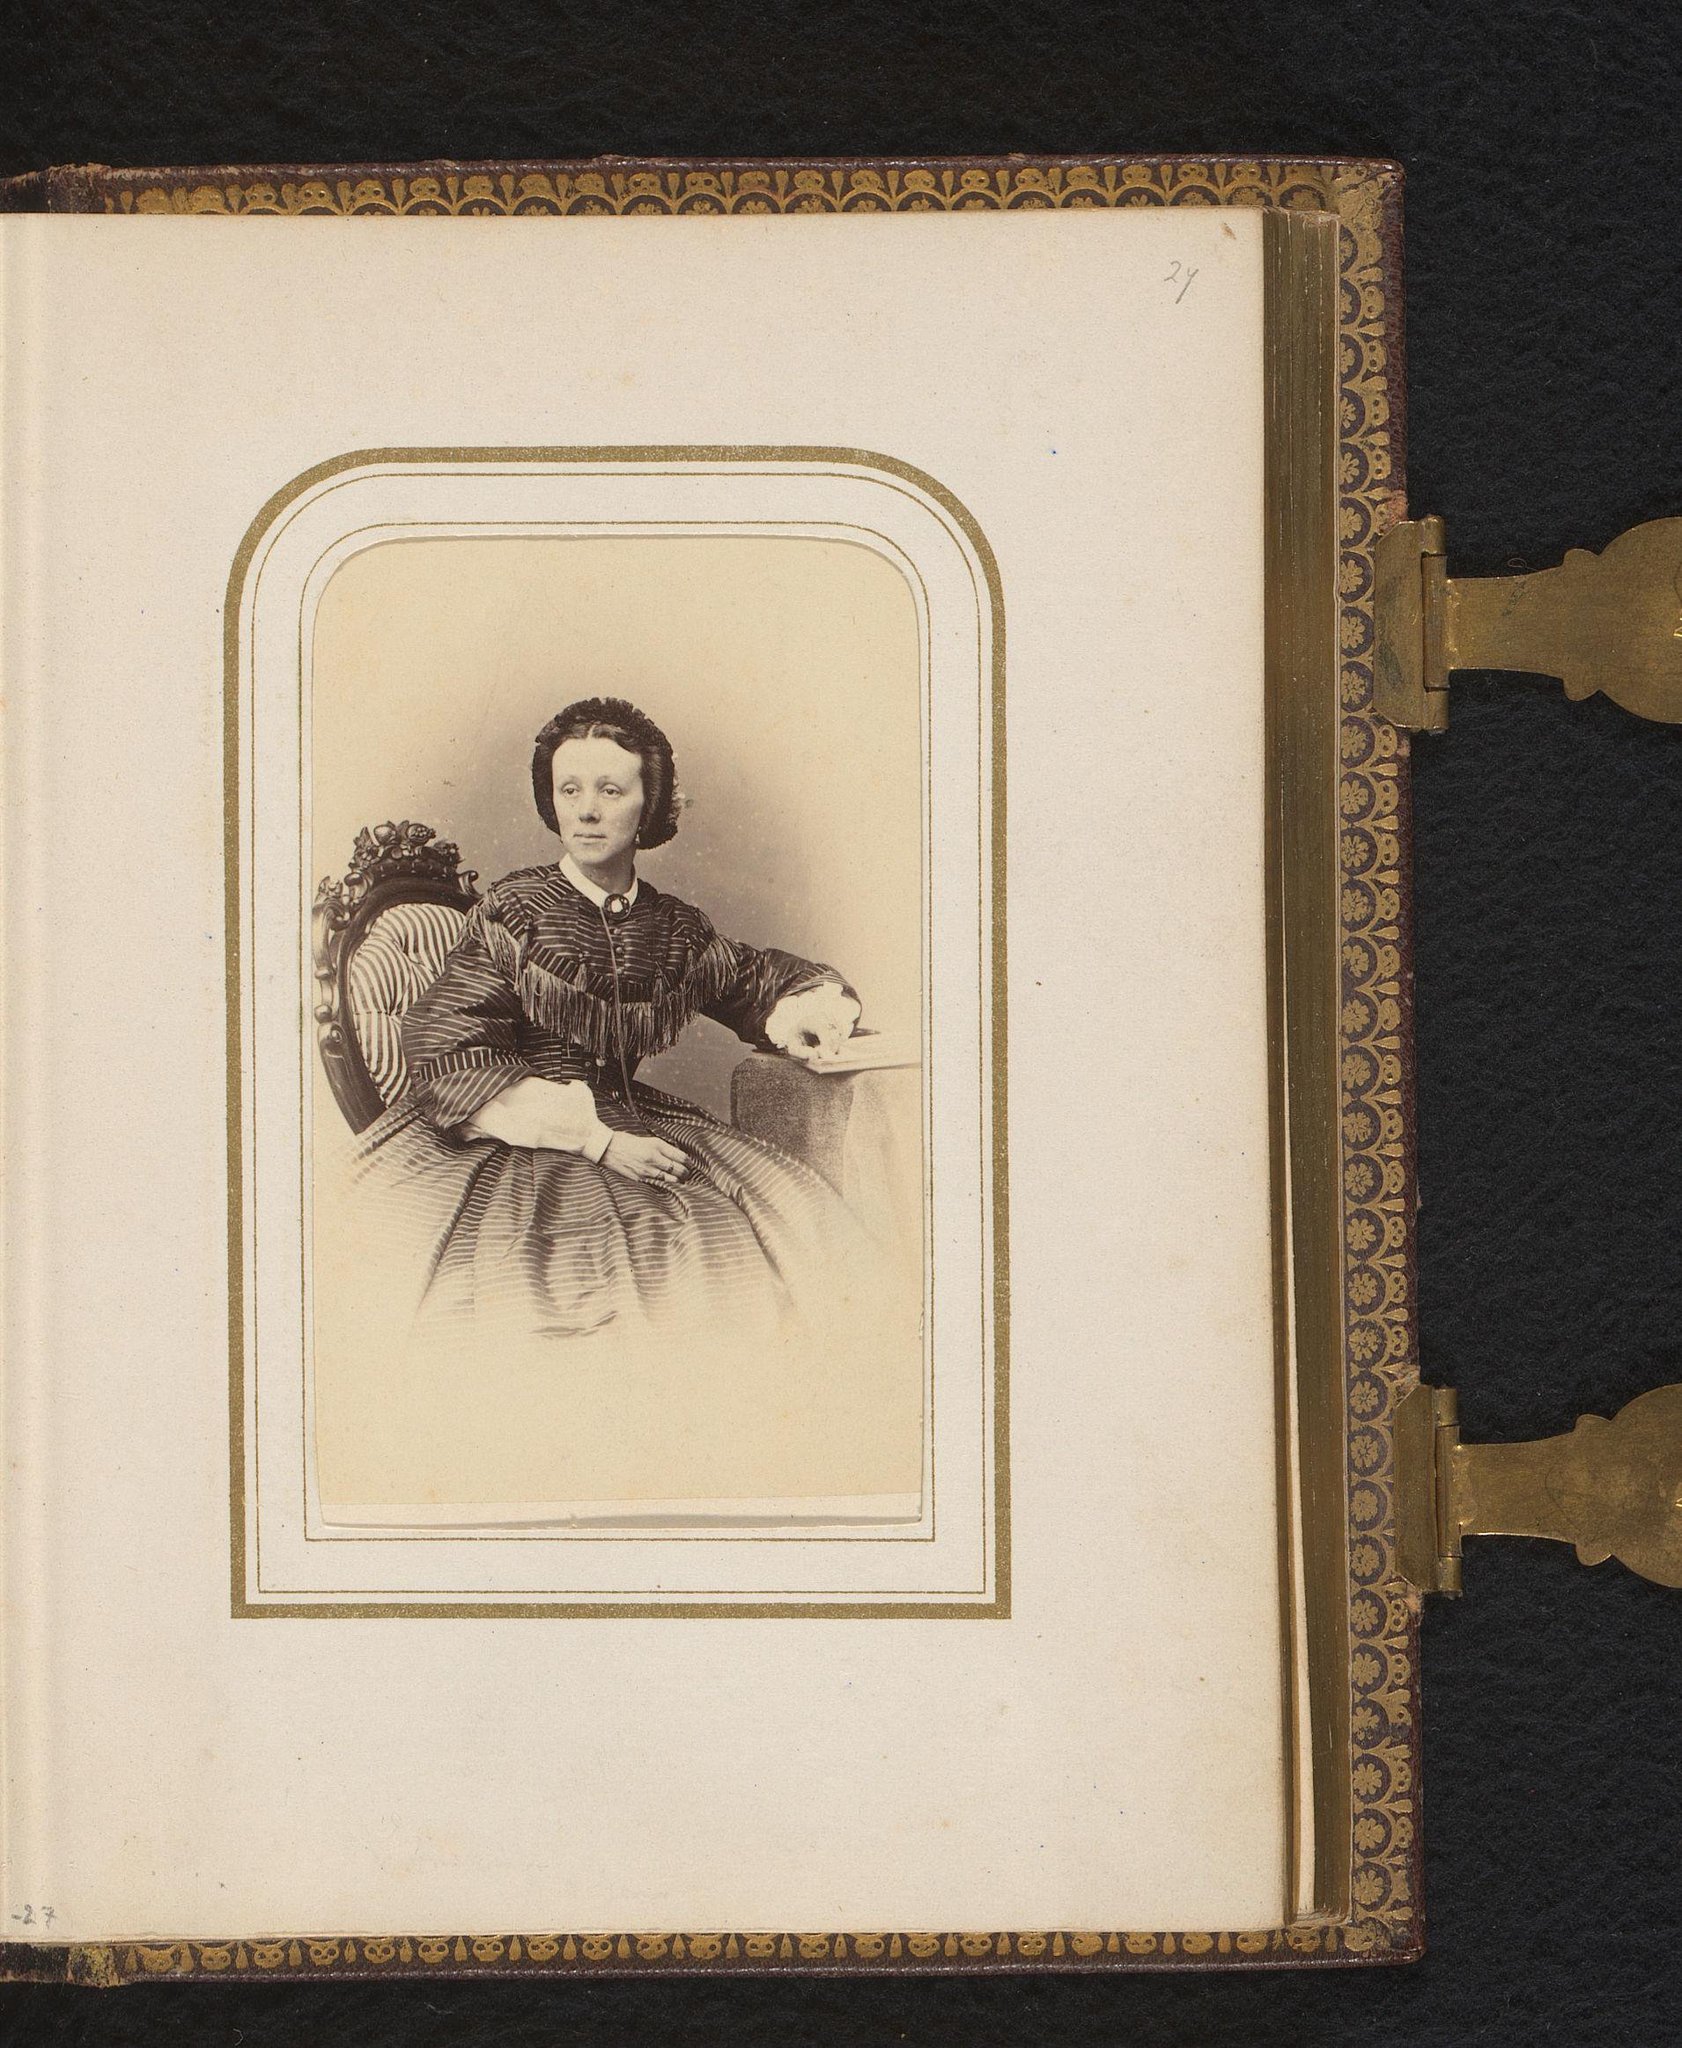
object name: photograph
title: Portret van een onbekende vrouw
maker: franz wilhelm deutmann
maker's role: fotograaf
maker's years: 1809-1895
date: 1860-1870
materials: cardboard, paper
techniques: albumen print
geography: amsterdam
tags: anonymous historical person portrayed - bb - woman